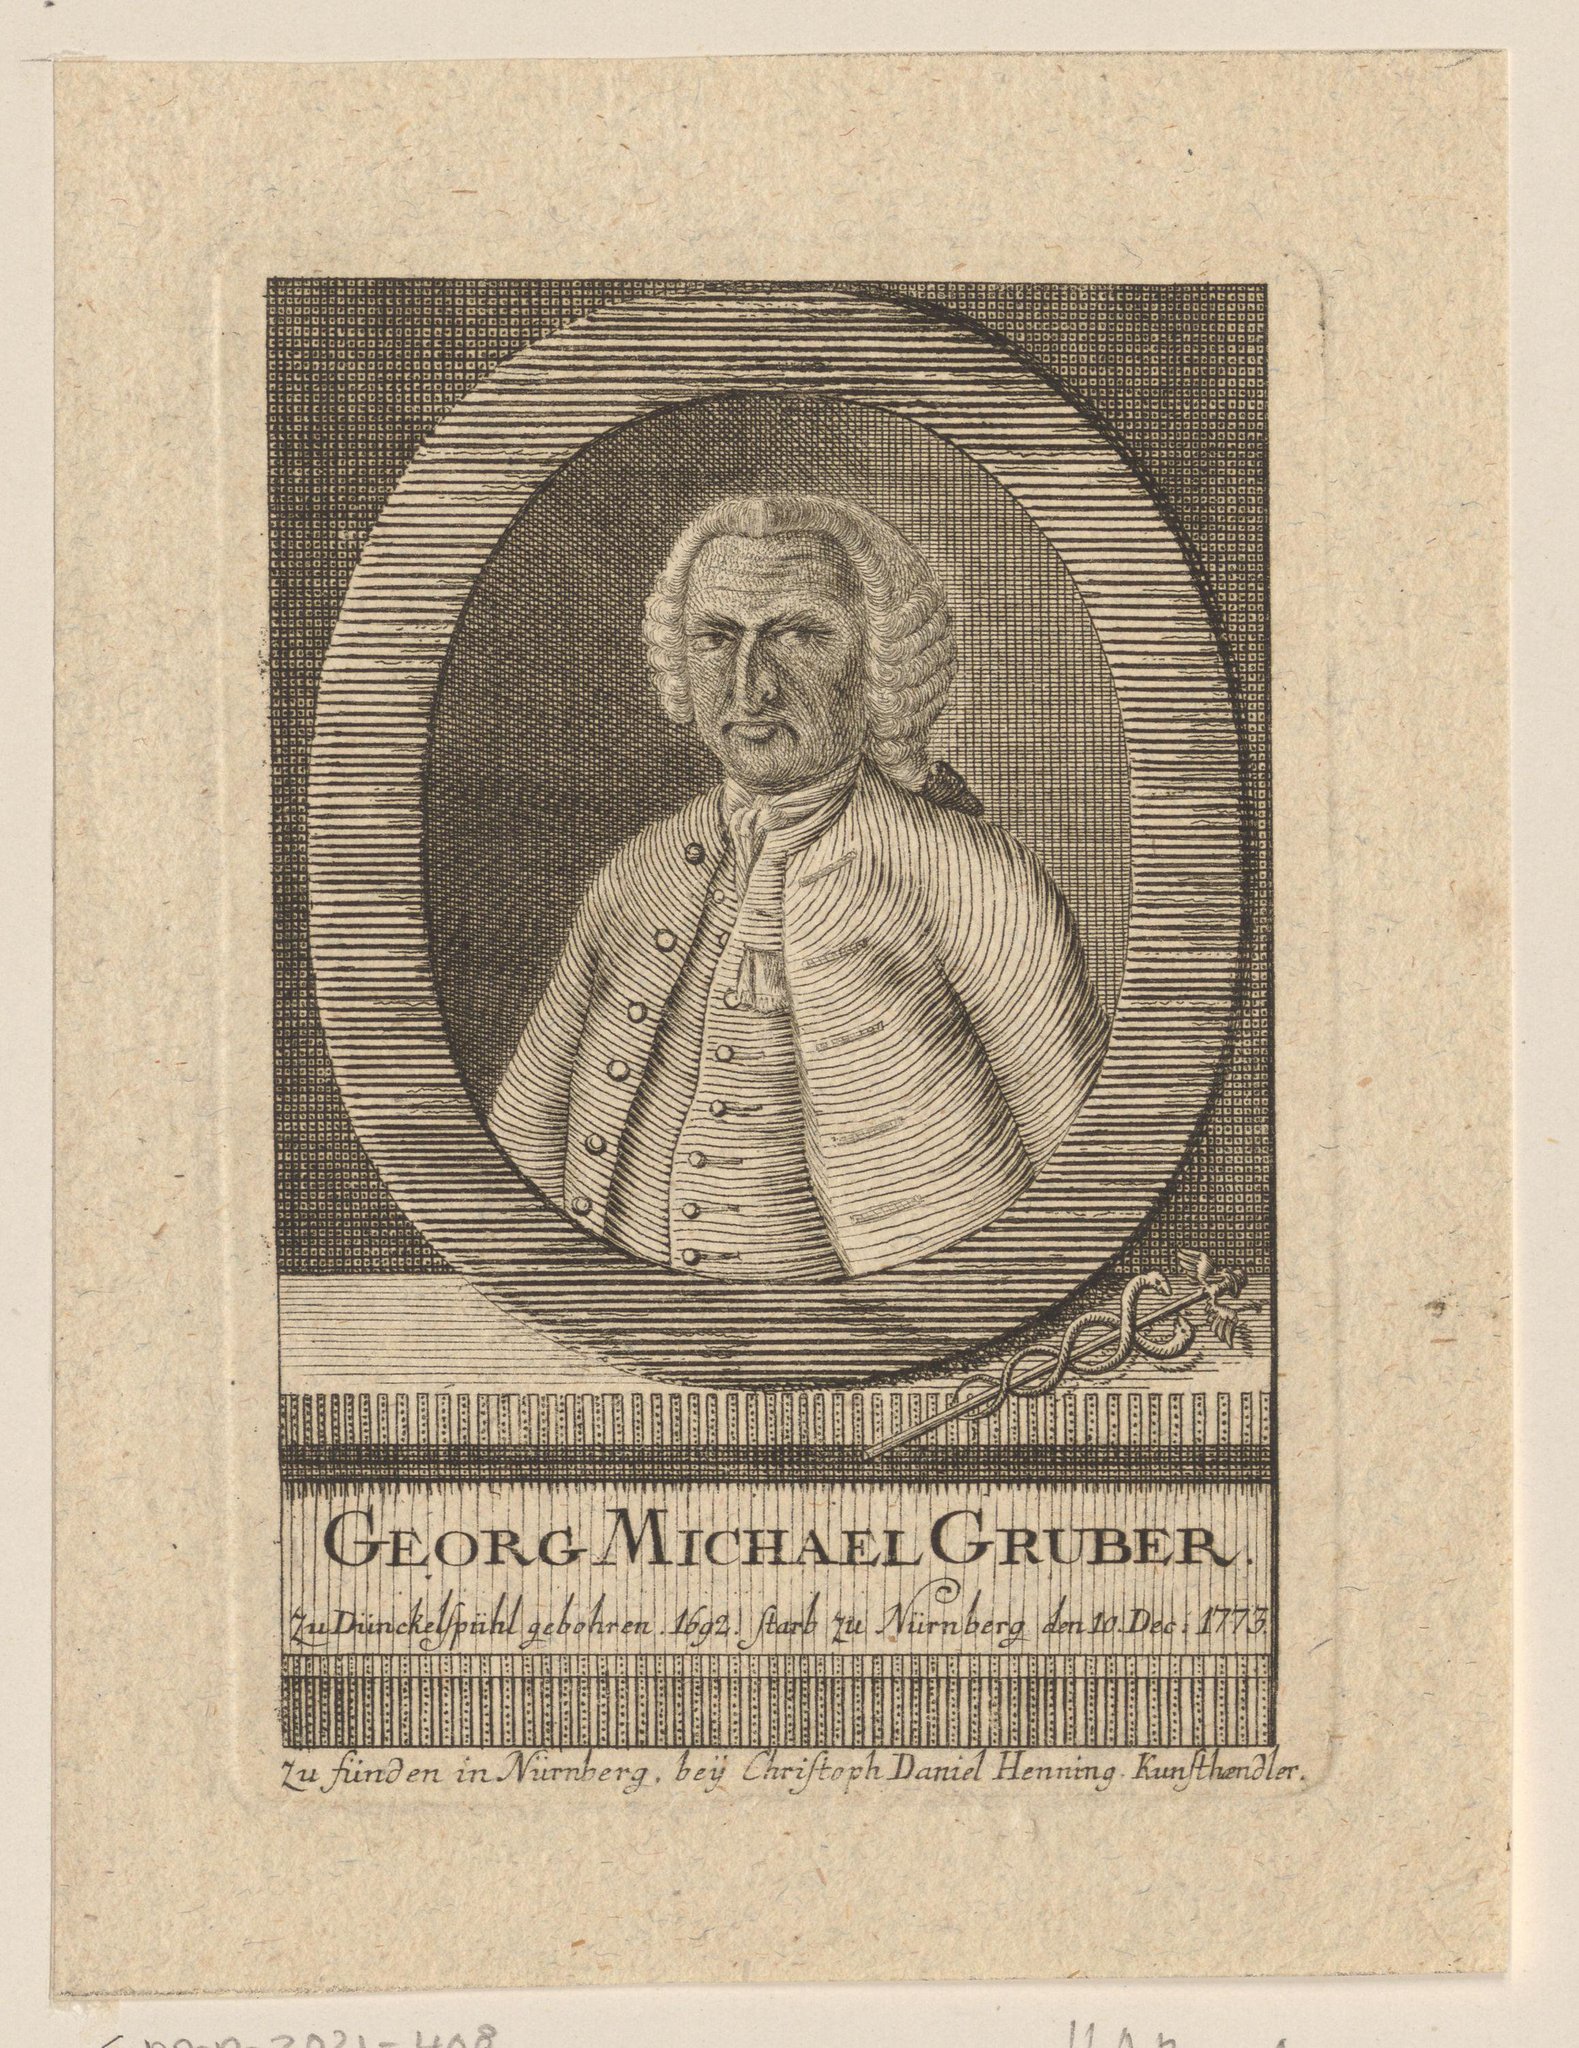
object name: print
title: Portret van Georg Michael Gruber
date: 1773-1795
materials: paper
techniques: engraving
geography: nuremberg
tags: historical persons